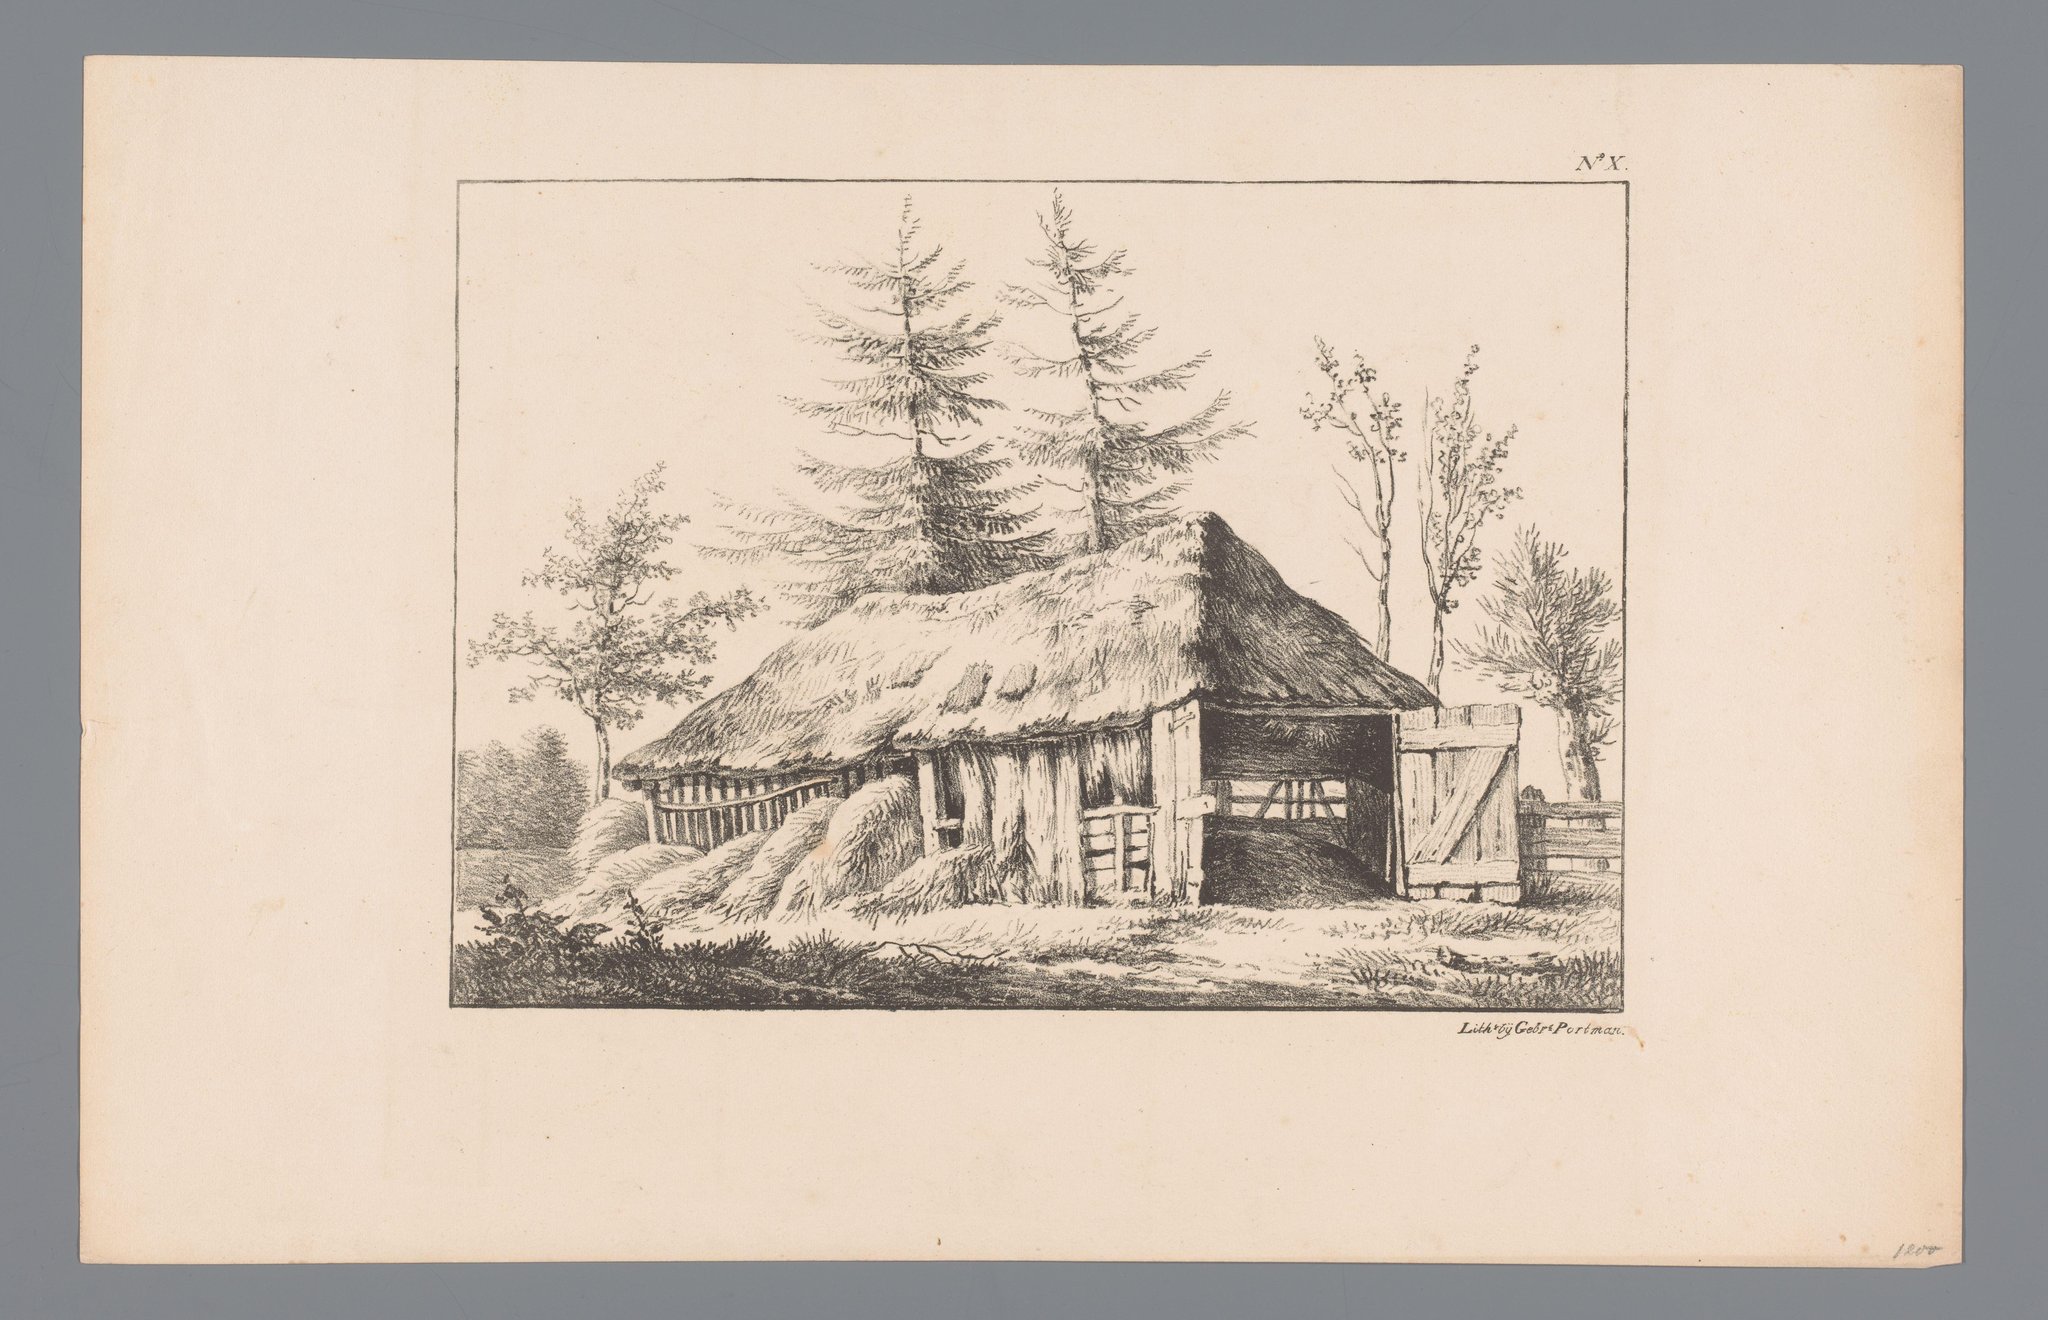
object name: print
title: Hooischuur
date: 1809-1845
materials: paper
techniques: lithograph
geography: amsterdam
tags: barn, hay-stack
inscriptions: collector's mark: Lugt 2228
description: Een hooischuur met geopende deuren in een landschap. Onderdeel van een omslag met een serie van zes landschappen.